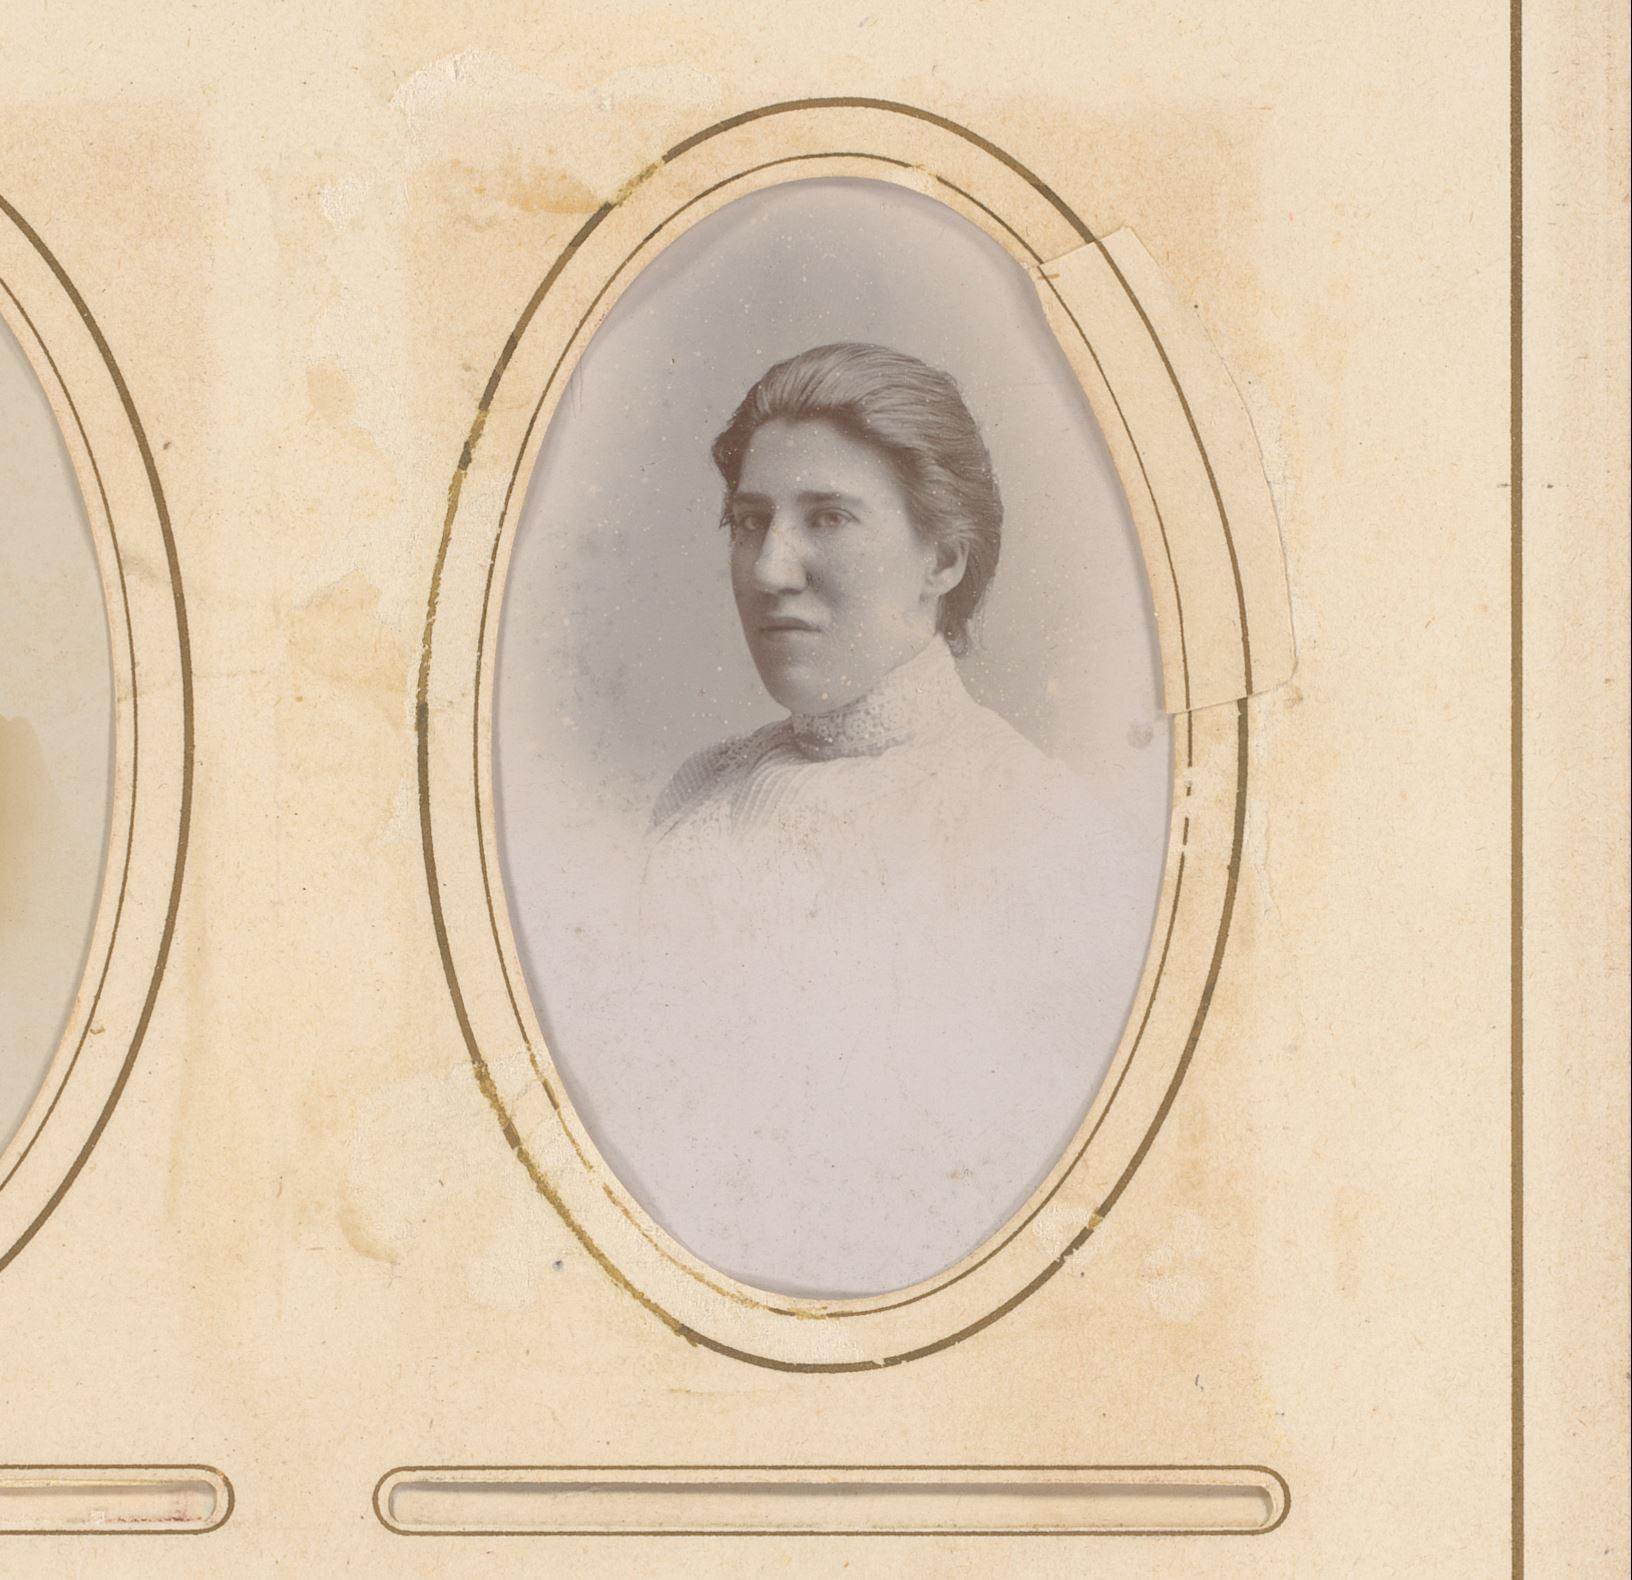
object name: album leaf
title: Portret van een vrouw met een hooggesloten jurk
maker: v.e. vandycke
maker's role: fotograaf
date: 1888-1906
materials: cardboard, photographic support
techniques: collodion silver print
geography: croydon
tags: historical persons - bb - woman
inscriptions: number: ‘3457-B’